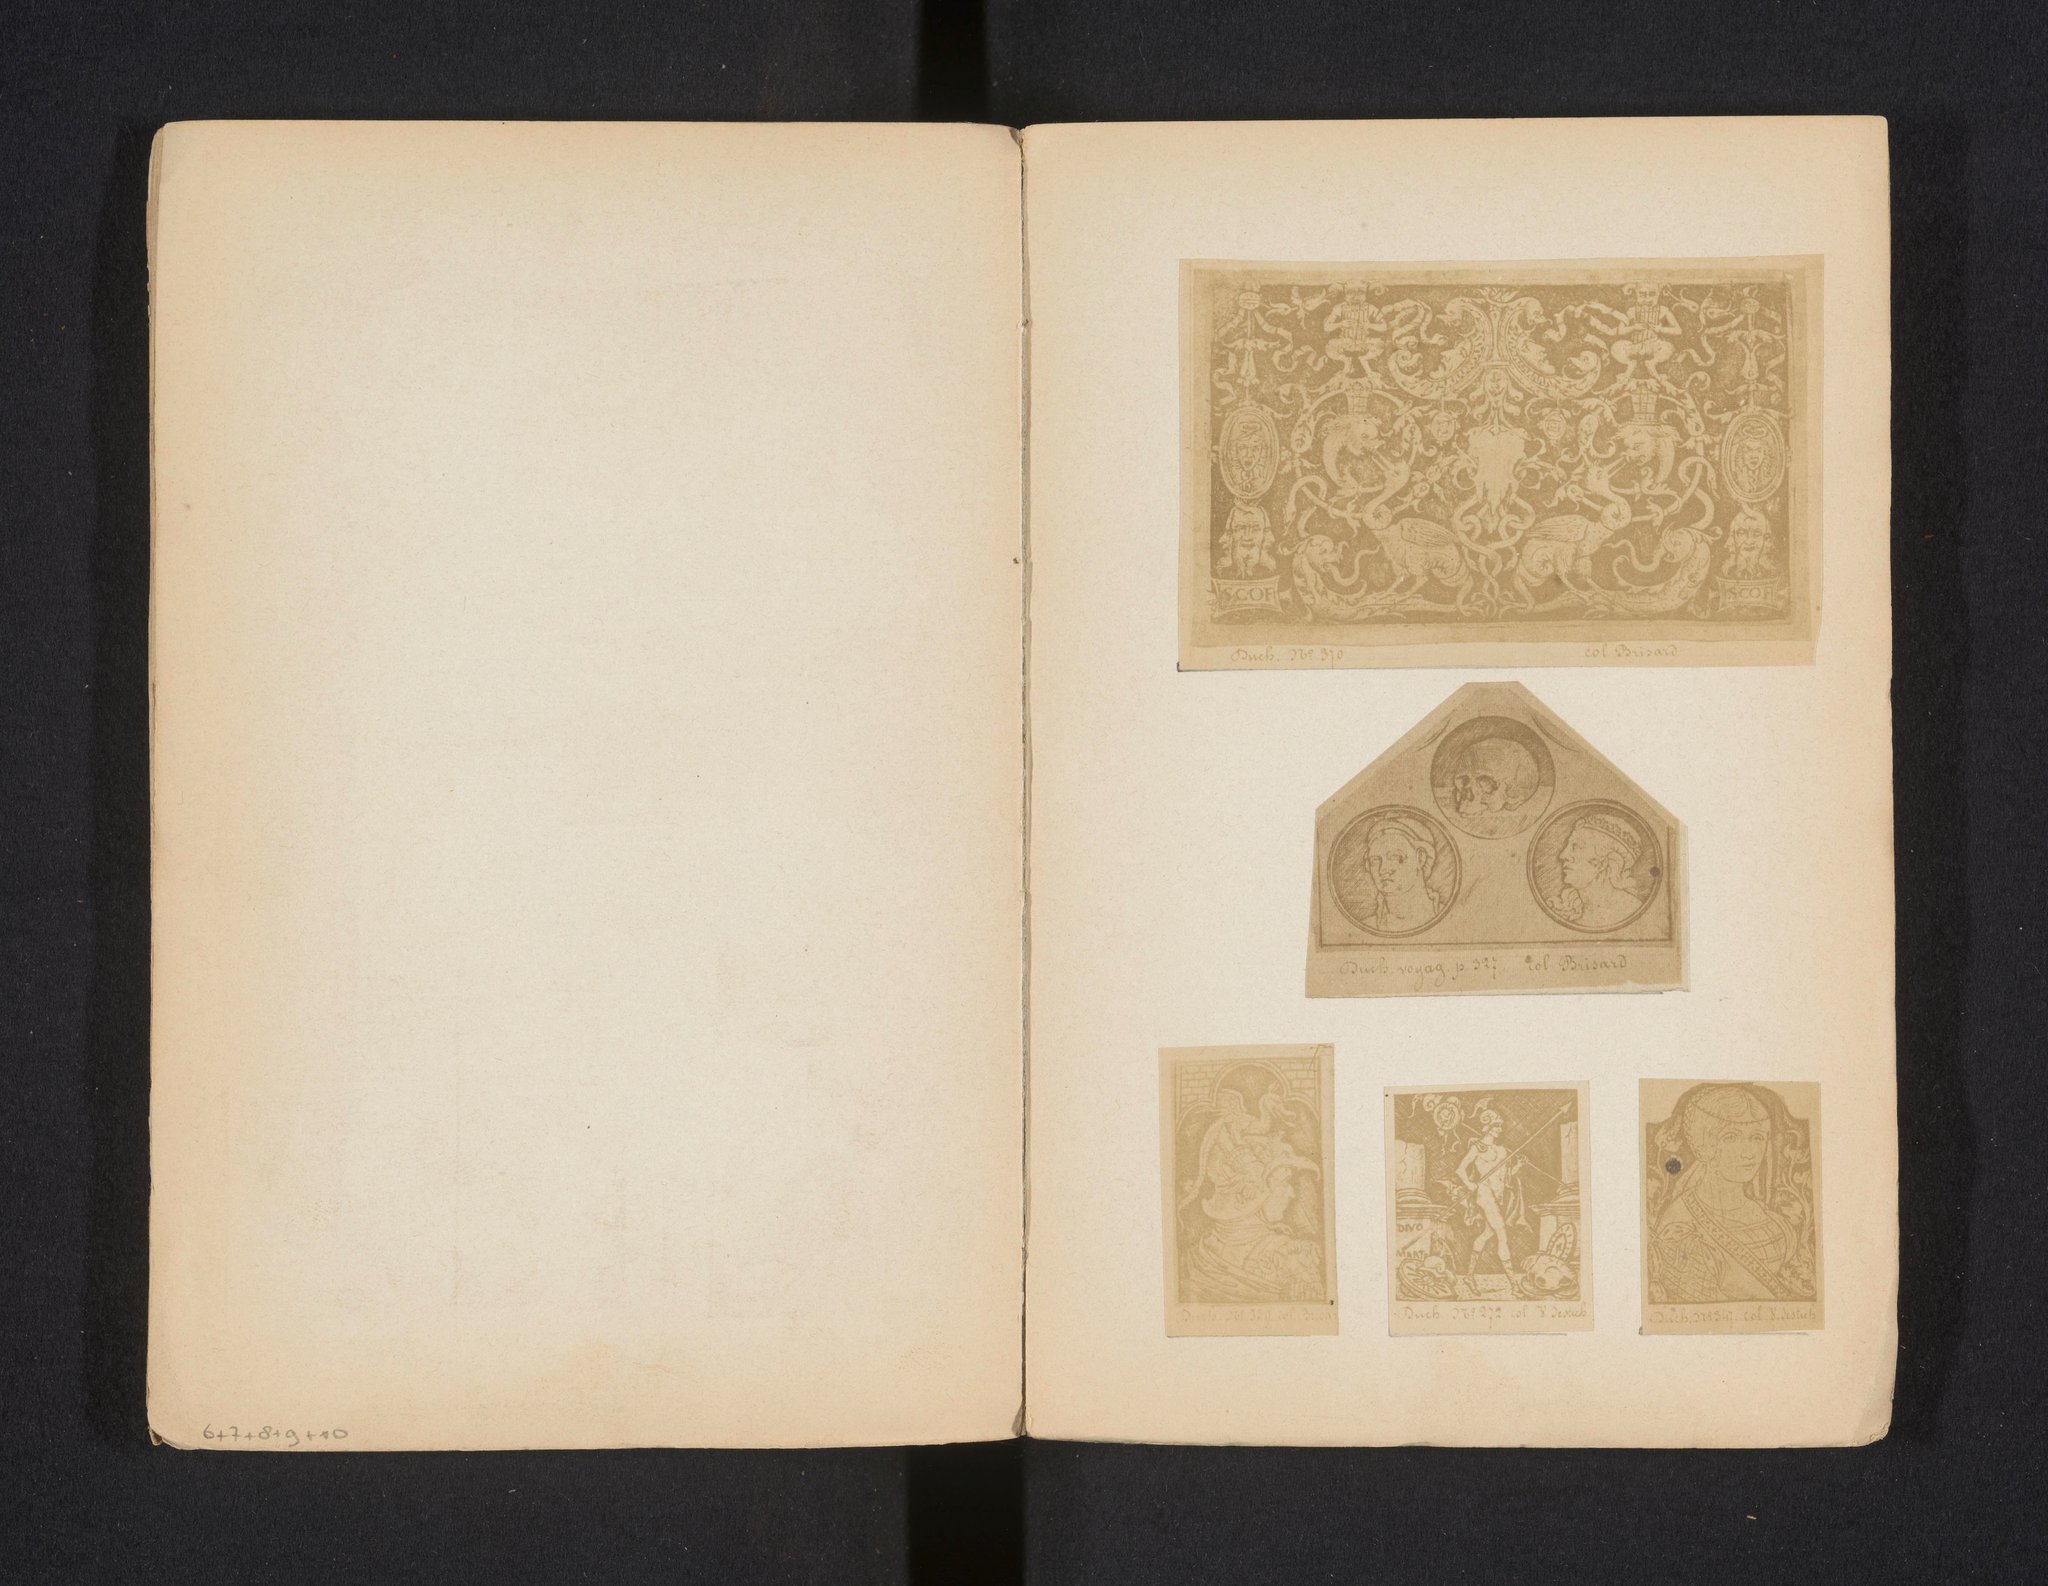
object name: photograph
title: Fotoreproductie van een prent van een portret van een onbekende vrouw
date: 1853-1858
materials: photographic support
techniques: salted paper print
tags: historical persons not known by name - bb - woman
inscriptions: inscription: ‘Duch. No 347. col. V. Sestich’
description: Foto op vijfde ongenummerde pagina na pagina 142.